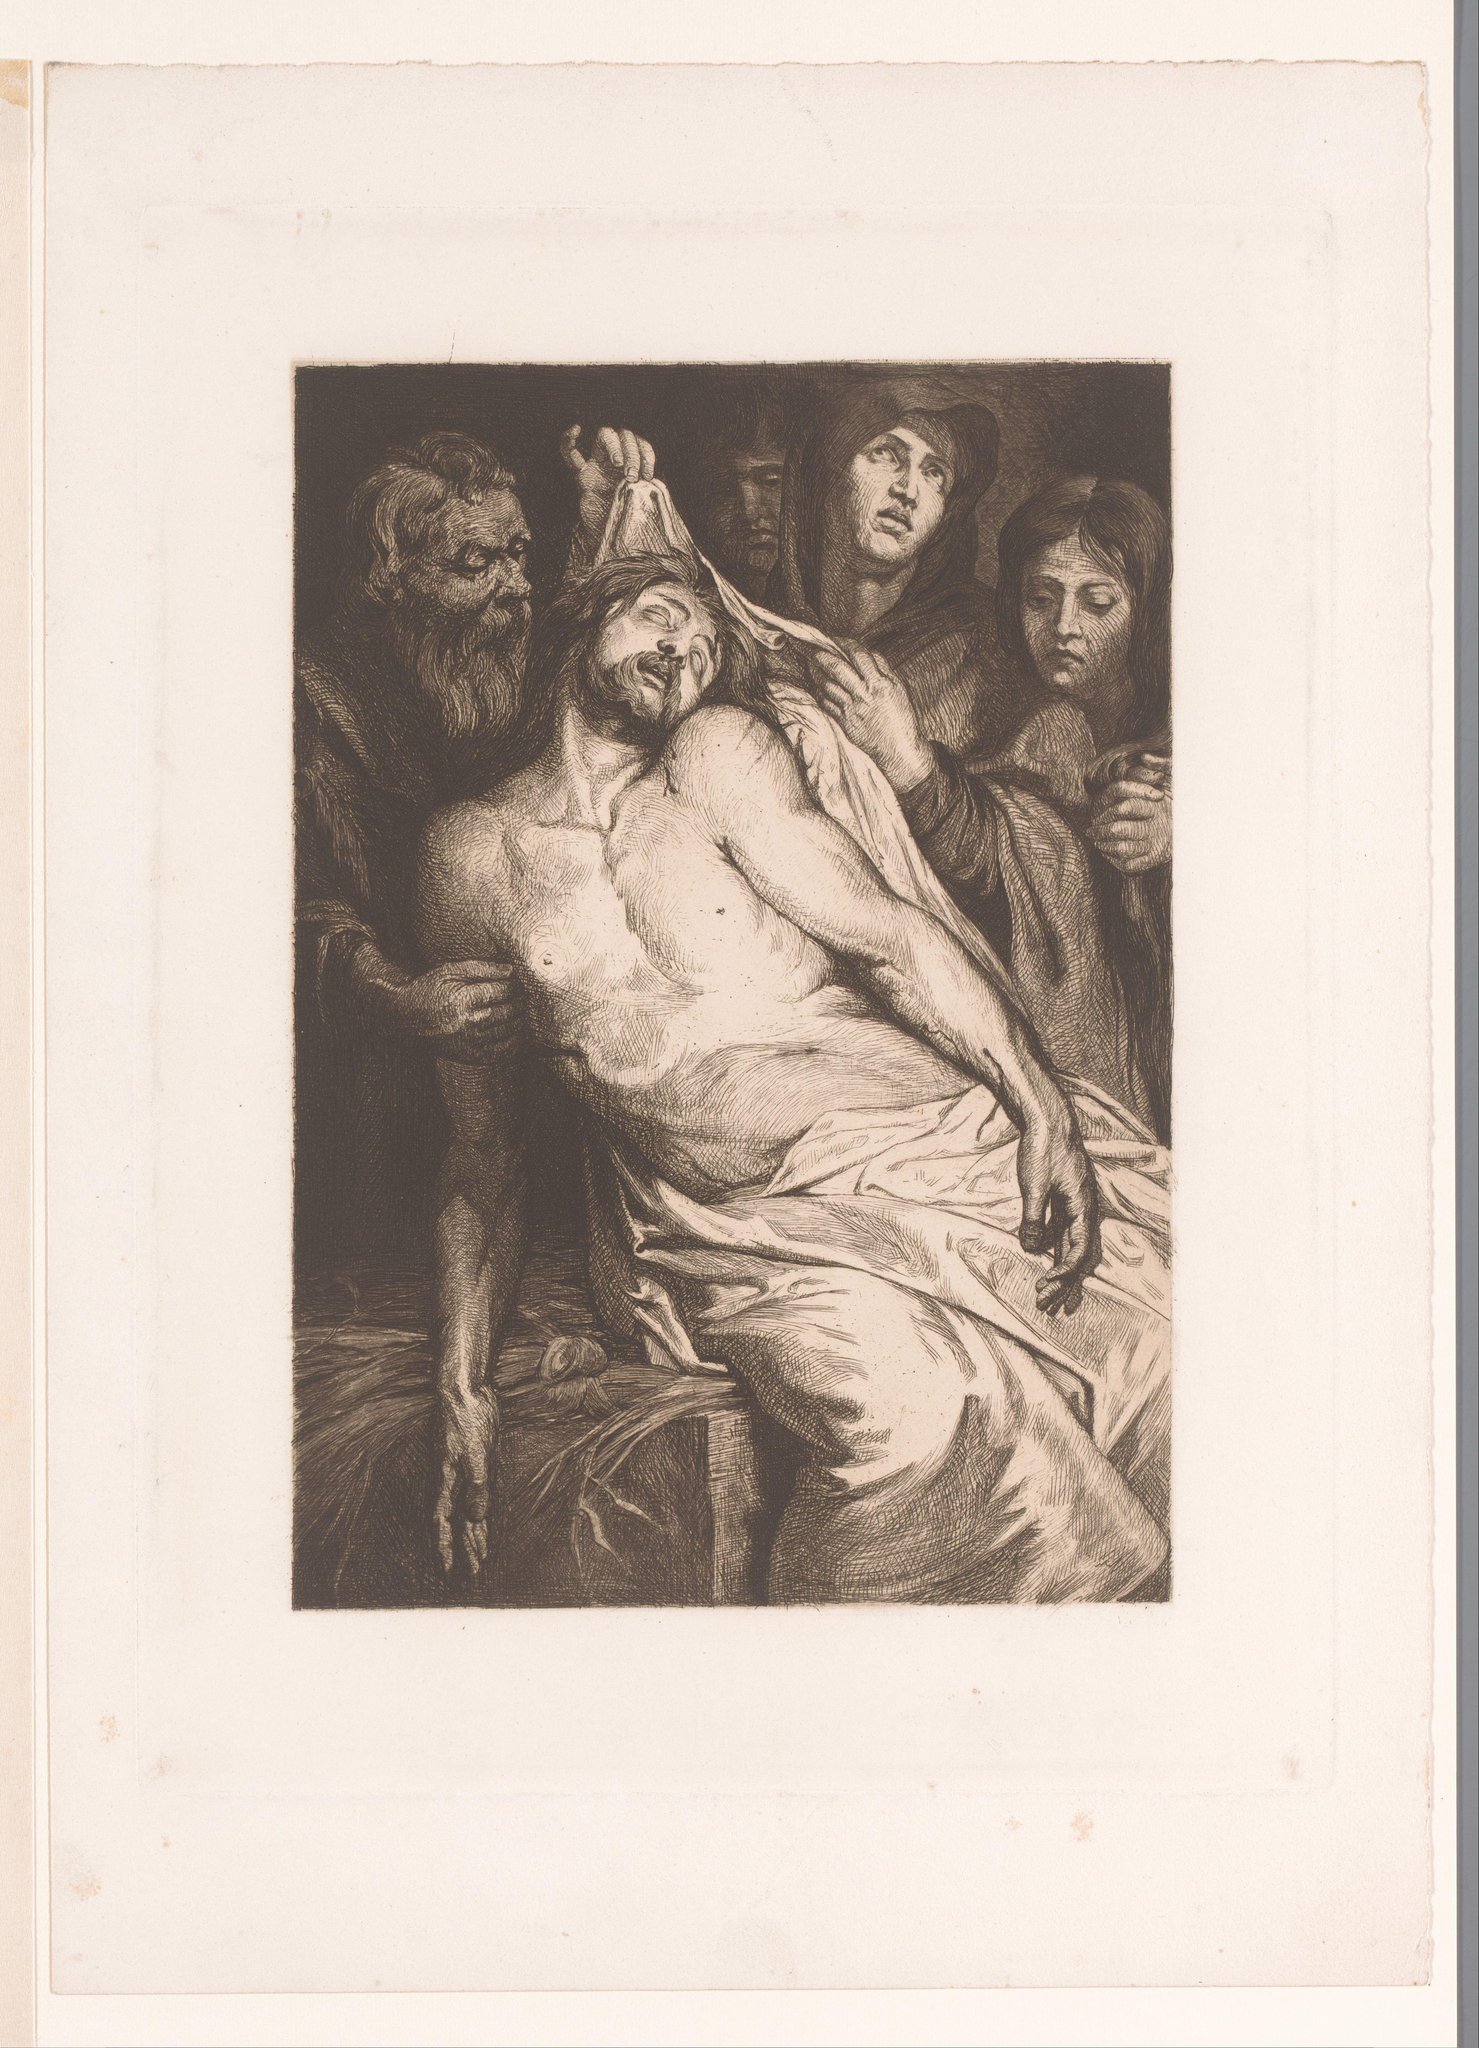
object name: print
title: Bewening van Christus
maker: josué dupon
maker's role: print maker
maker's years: 1864-1935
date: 1874-1909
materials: paper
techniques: etching, intaglio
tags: the mourning over the dead christ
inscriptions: collector's mark: Lugt 2228